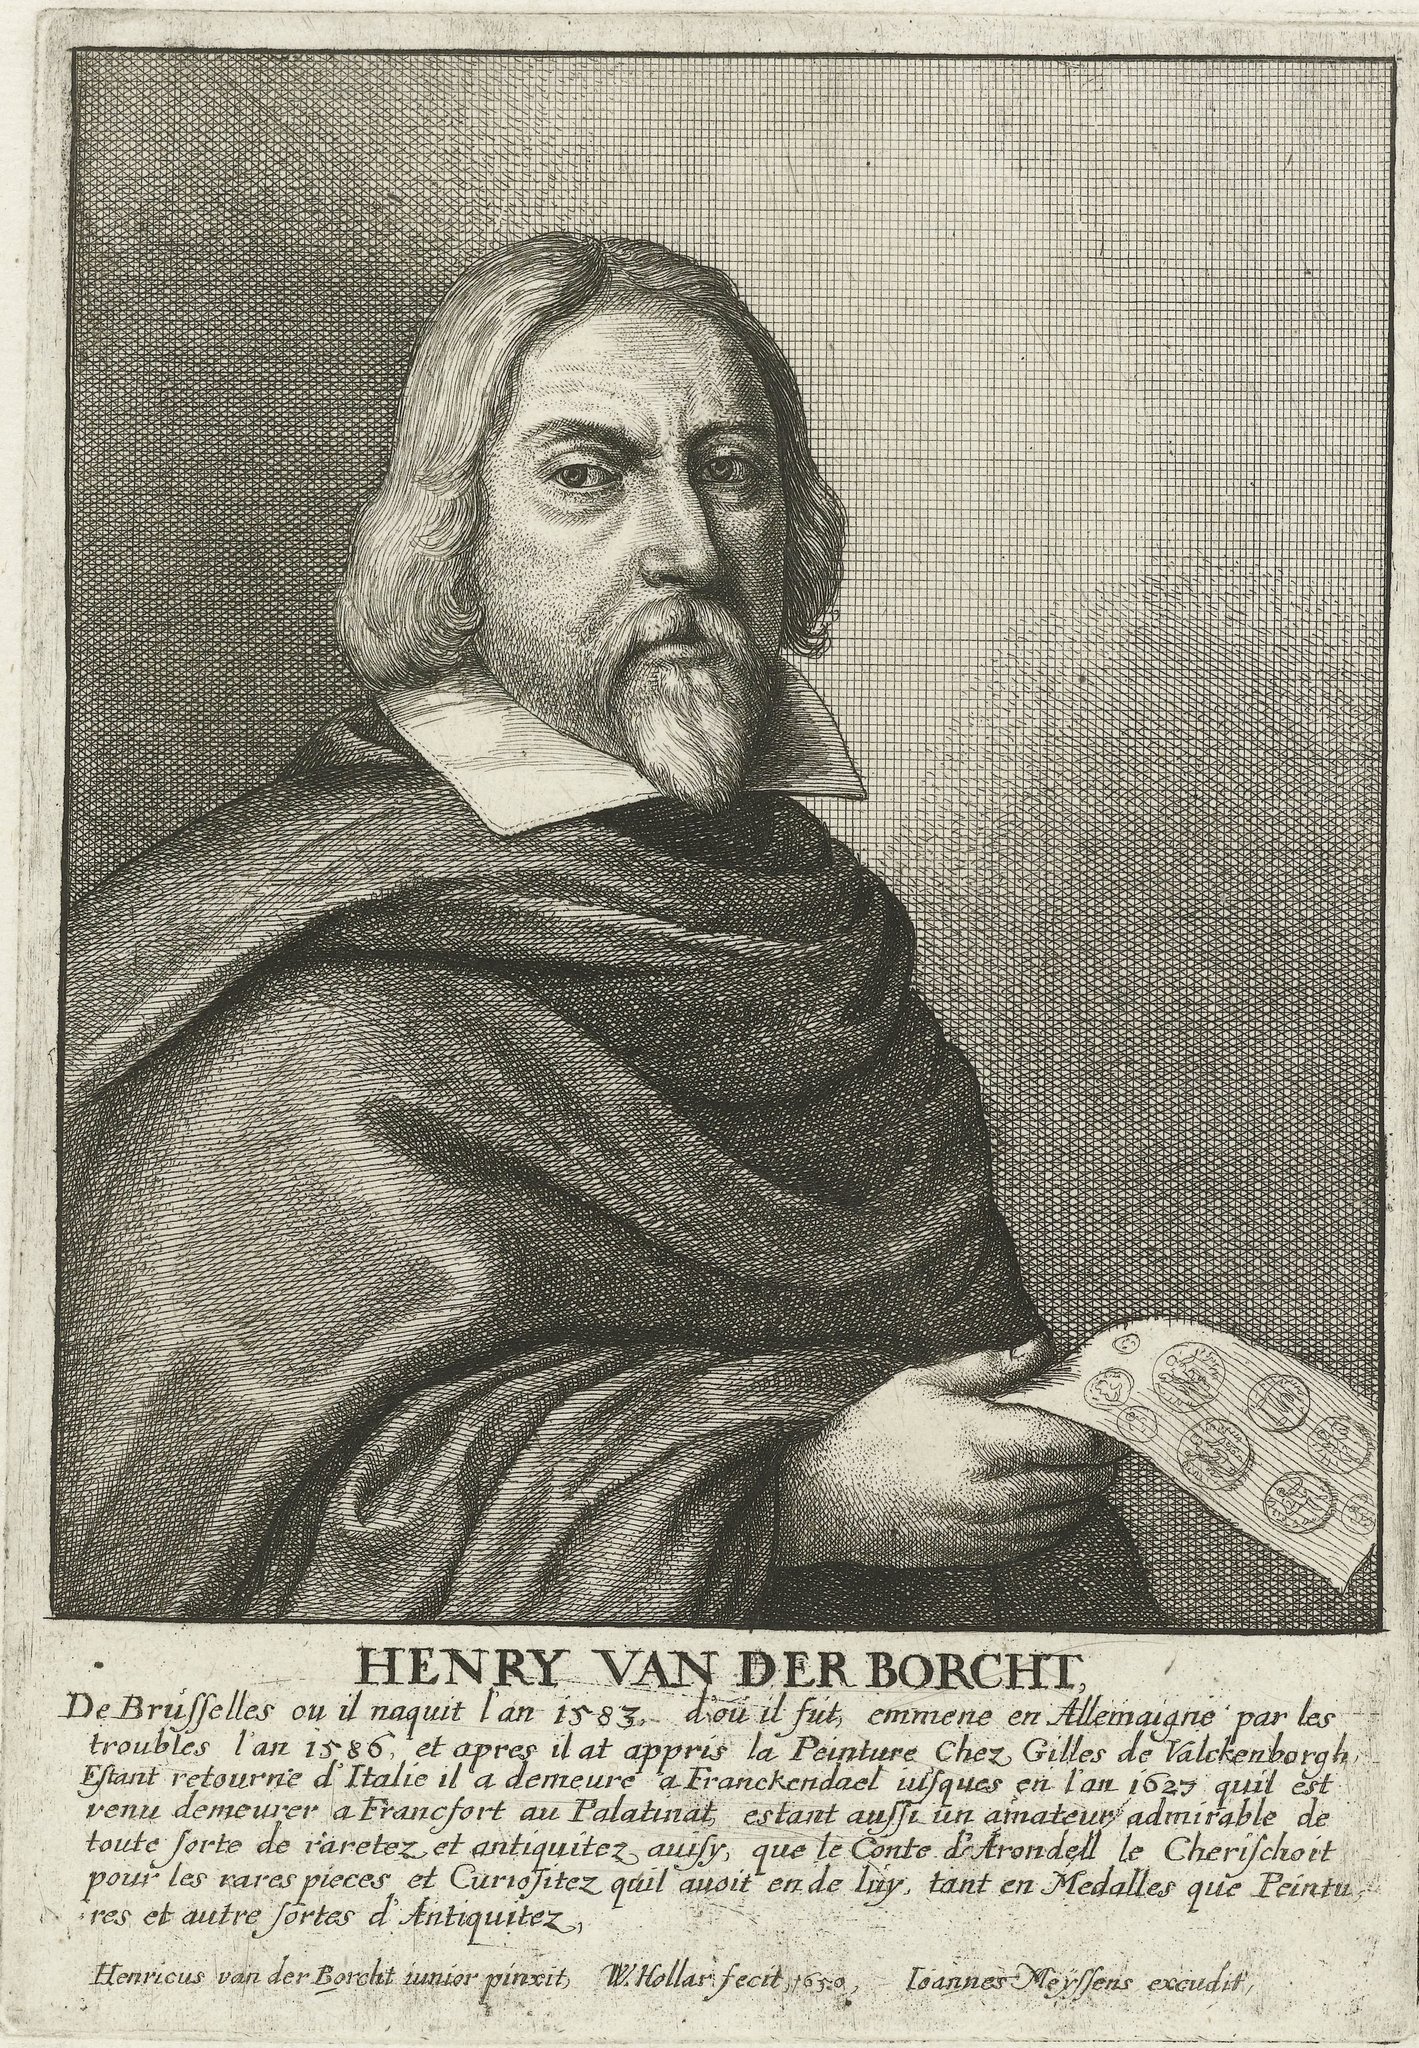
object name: print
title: Portretten van kunstenaars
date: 1650-1670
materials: paper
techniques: etching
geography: antwerp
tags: brussels, print maker, hendrik van der borcht (i)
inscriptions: collector's mark: Lugt 1337, collector's mark: Lugt 240, collector's mark: Lugt 887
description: De prent maakt deel uit van de negendelige serie "Image de divers hommes desprit sublime".